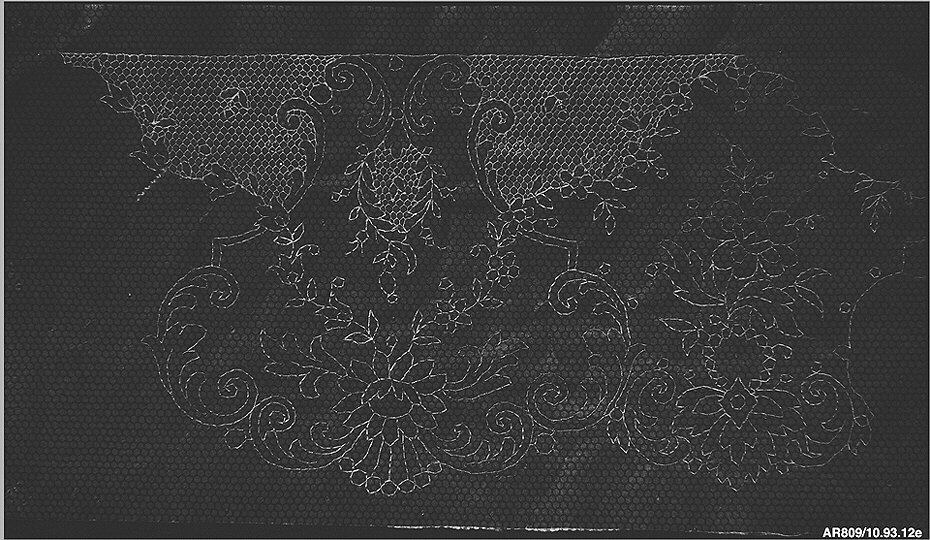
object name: sample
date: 1801-1900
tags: flowers